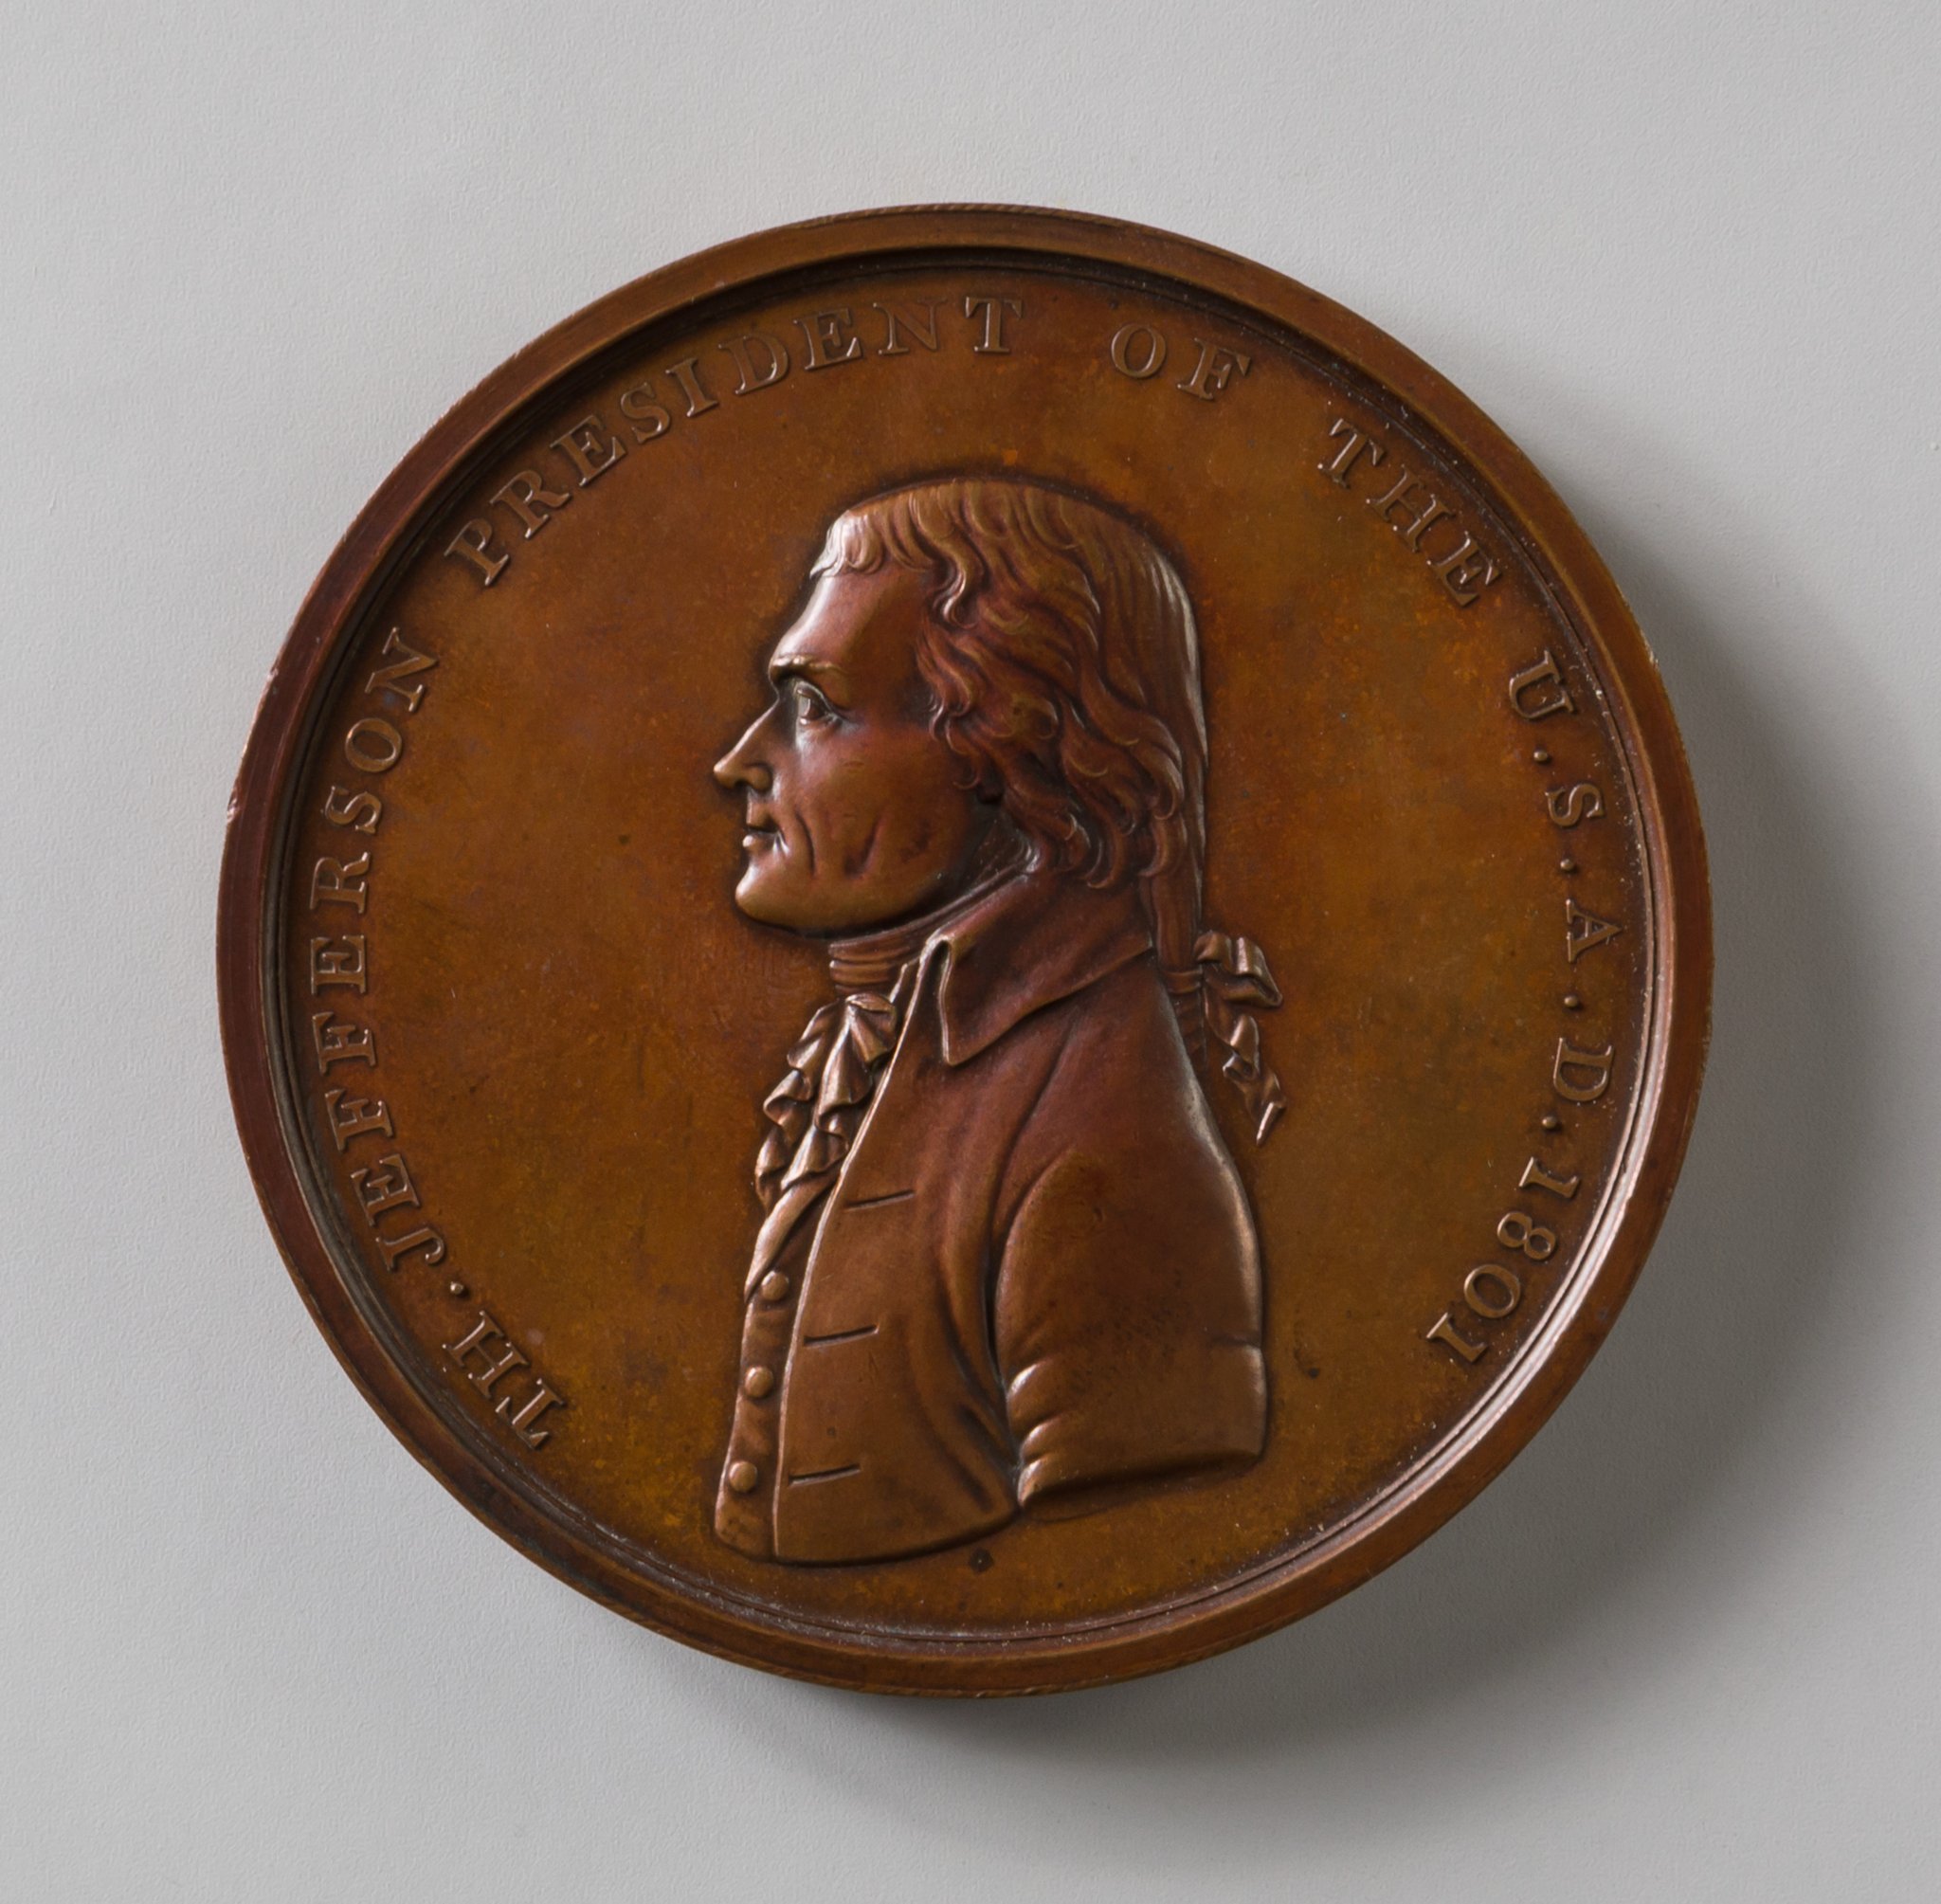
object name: medal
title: Thomas Jefferson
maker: johann mathias reich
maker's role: artist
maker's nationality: american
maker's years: 1768-1833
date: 1801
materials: bronze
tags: thomas jefferson,hands,men,profiles